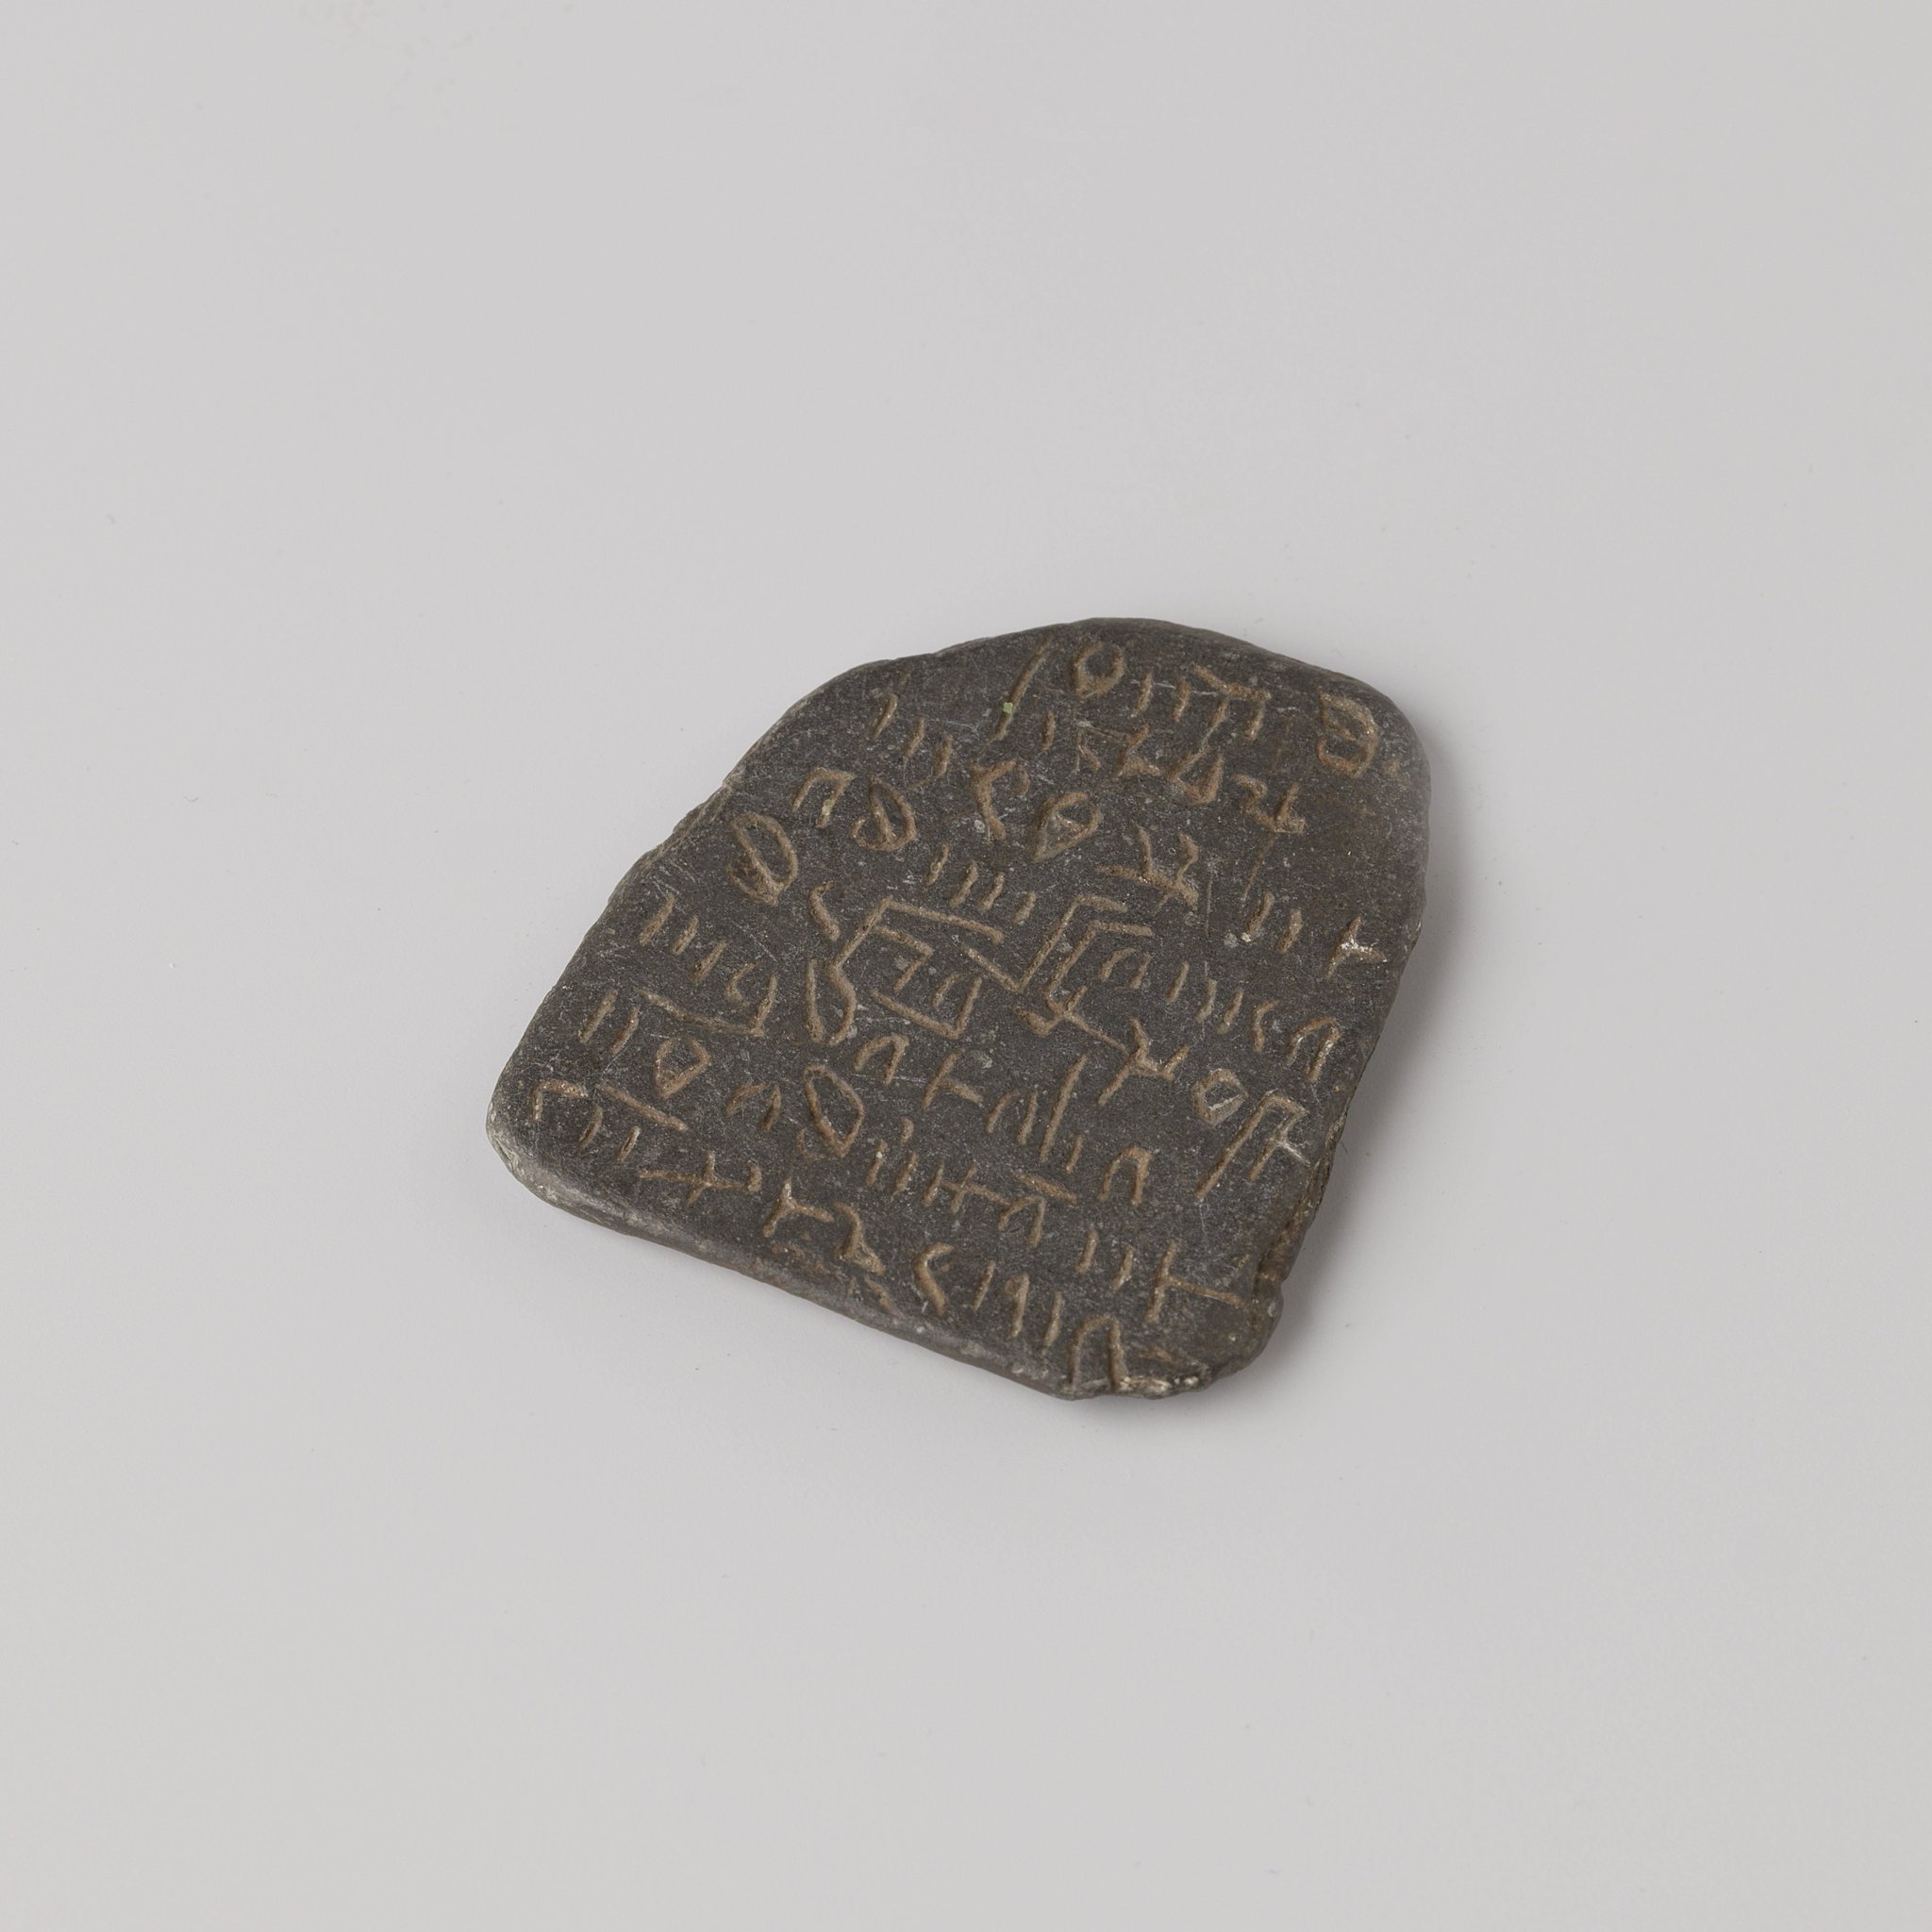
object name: lei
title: Latijns grafschrift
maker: Anonymous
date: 500-1000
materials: stone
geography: deventer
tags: deventer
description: Stukje lei met ingekraste inscriptie. Afkomstig uit Deventer. Was ooit samen met twee andere in een stuk papier gewikkeld.